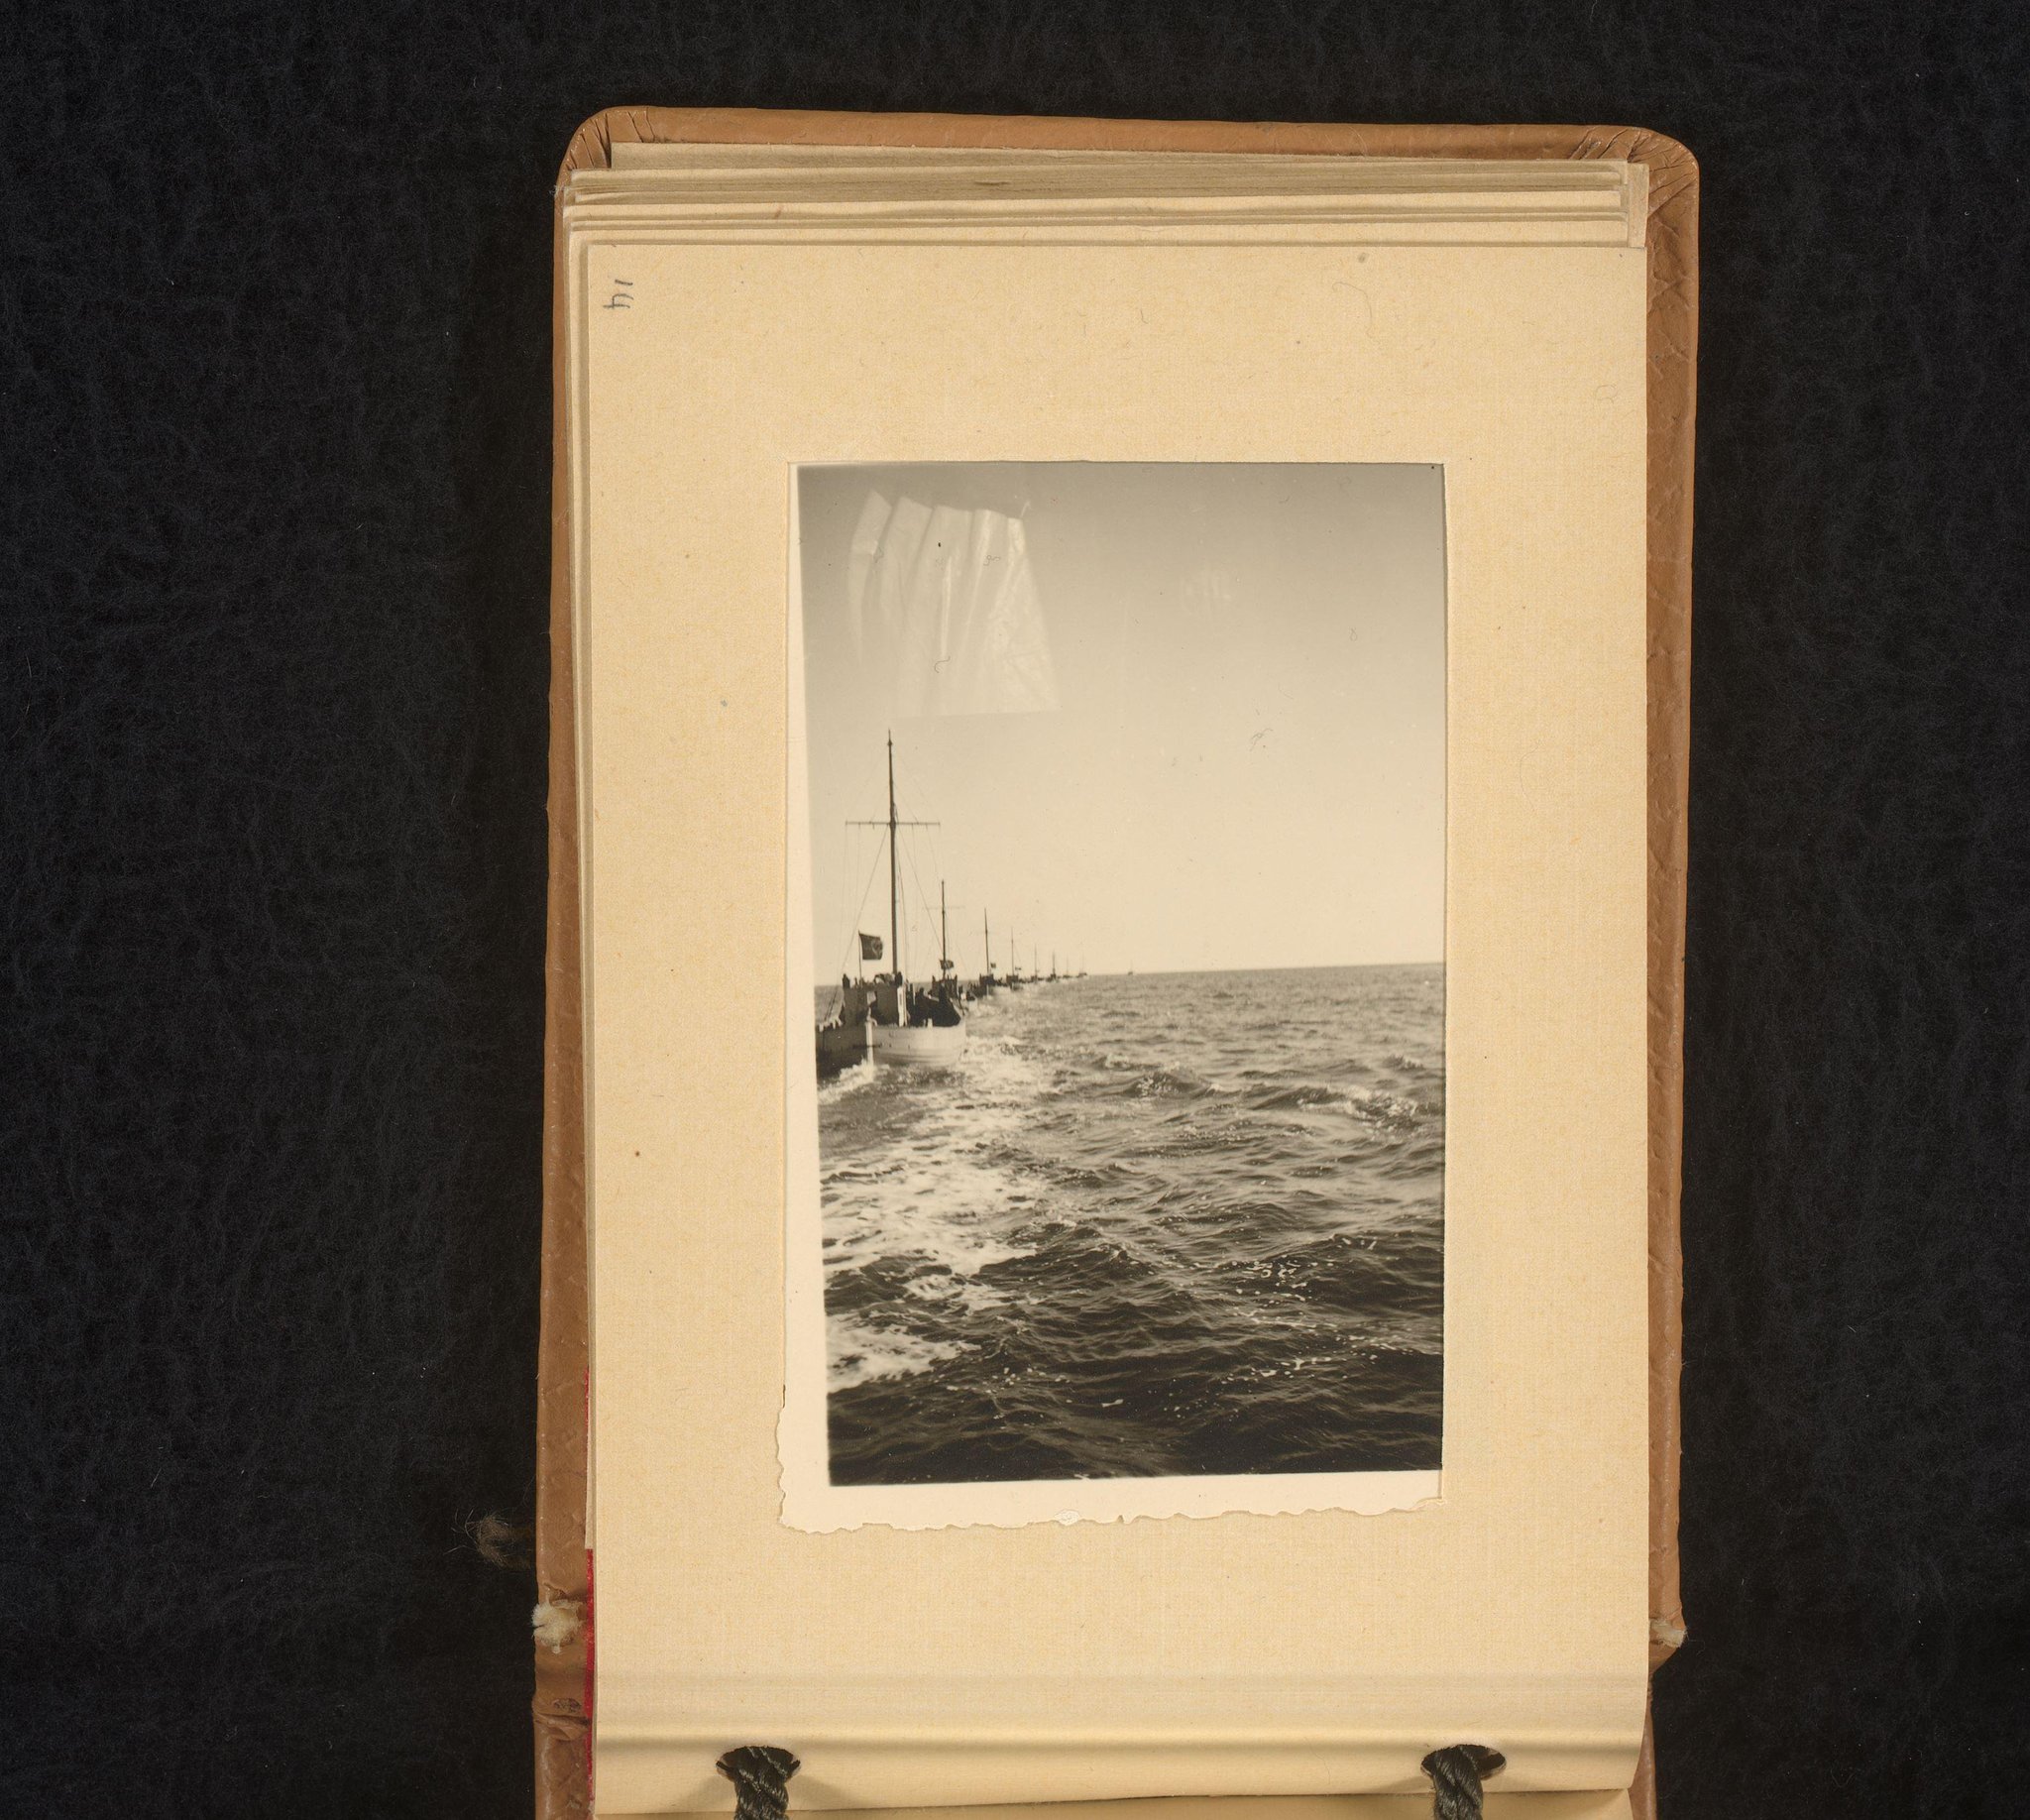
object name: album leaf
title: Vloot schepen van de Kriegsmarine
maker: Anonymous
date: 1940-1943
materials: paper, photographic support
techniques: gelatin silver print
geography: netherlands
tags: navy (+ motor ships), occupation ~ war, netherlands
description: Albumblad met een foto van een vloot schepen van de Kriegsmarine op zee. Onderdeel van een klein album van de Kriegsmarine in Nederland.